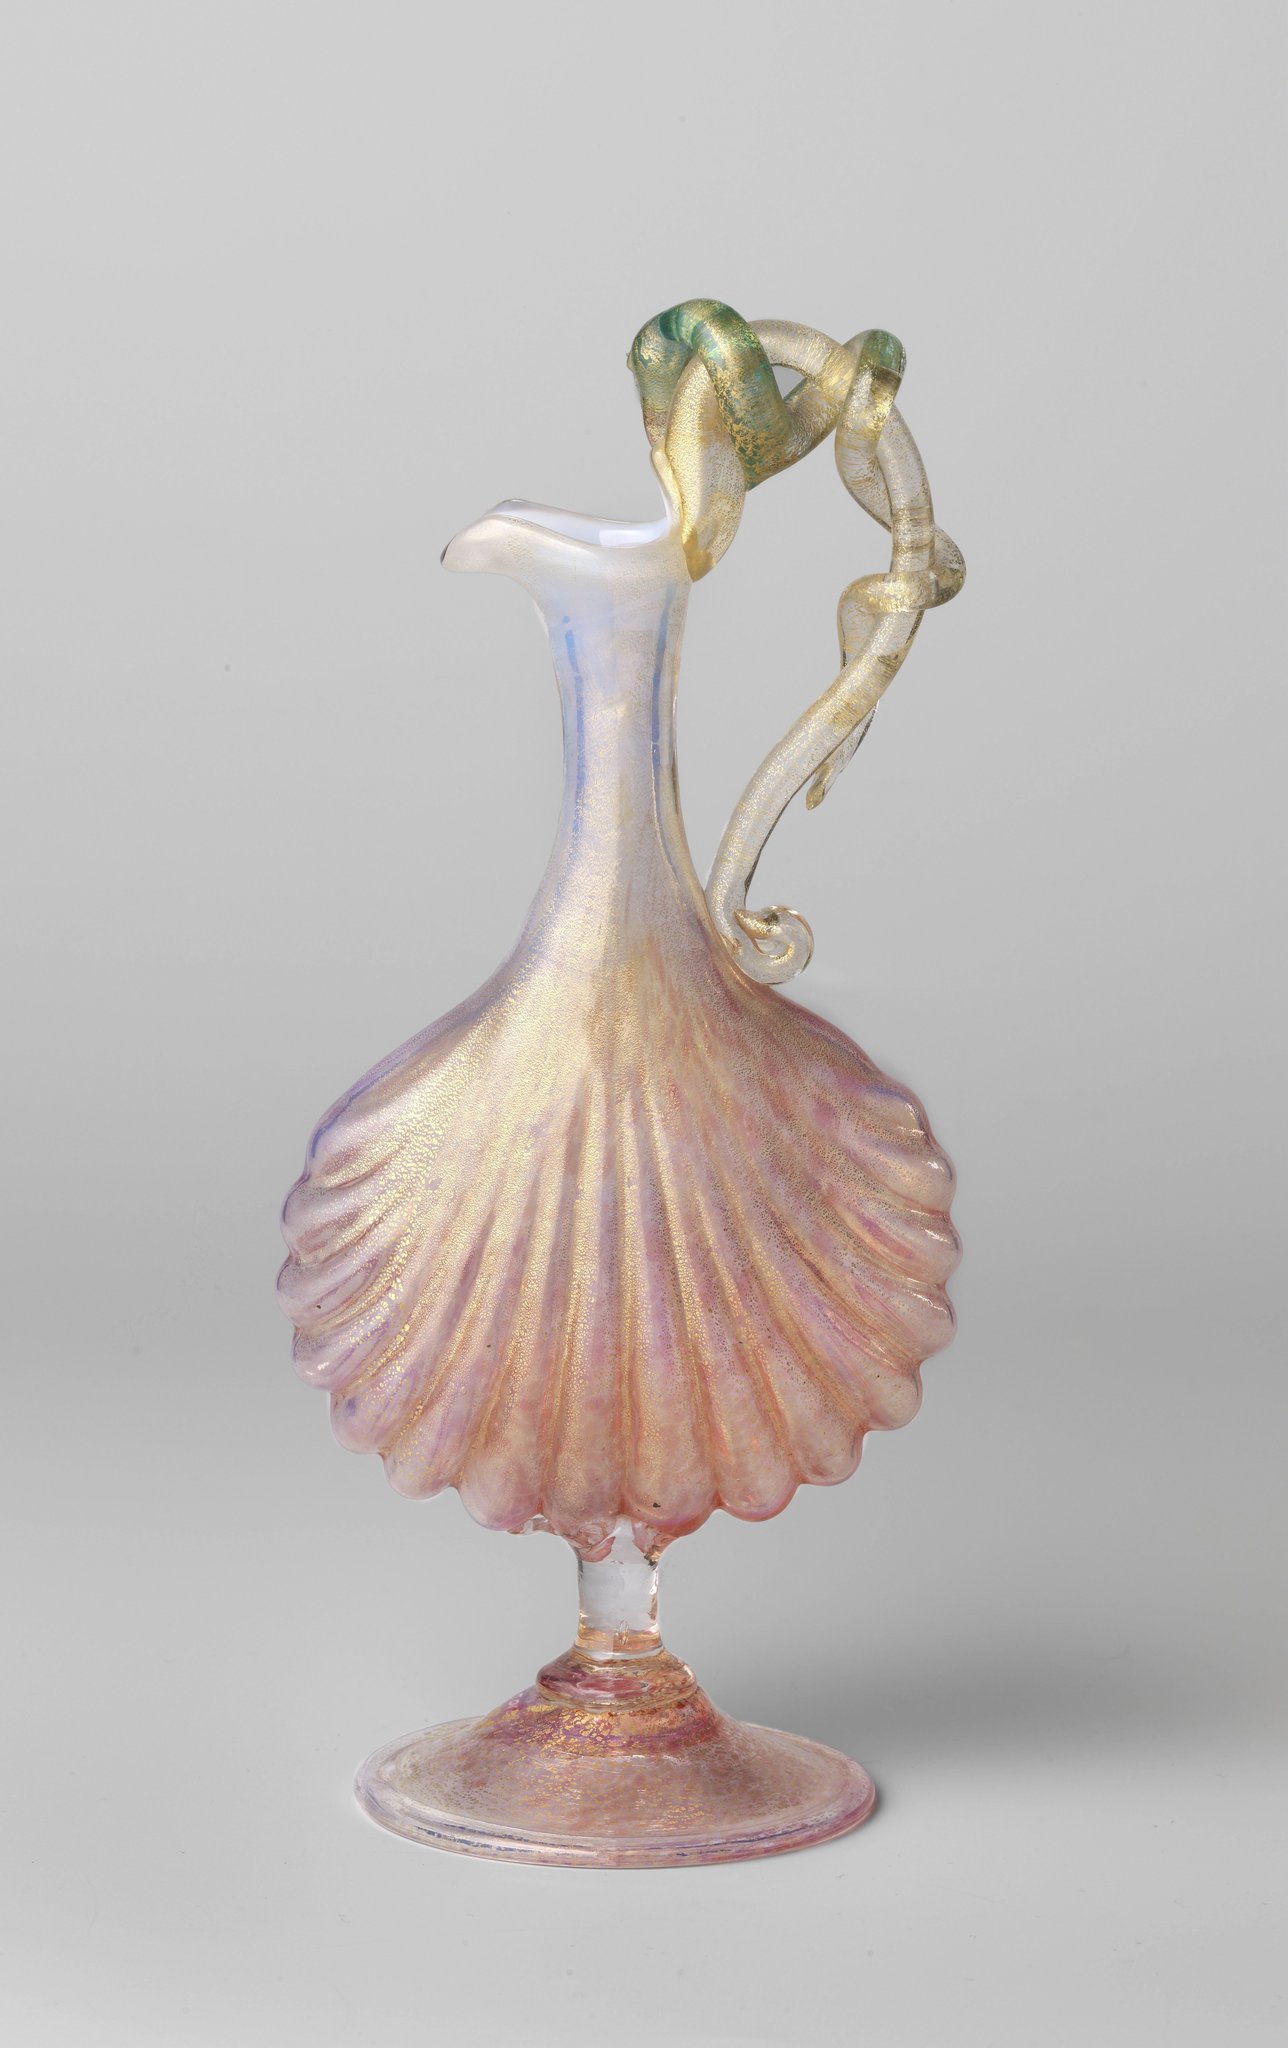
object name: vase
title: Two small vases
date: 1885-1890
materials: glass, gold leaf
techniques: glassblowing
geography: murano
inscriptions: label: ‘SALVIATI / 16 AVe DE L'OPERA / PARIS’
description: Roze-opaal glazen vaas met bladgoud (verpulverd) in de vorm van een kamschelp, aan het hengsel een kronkelende slang.